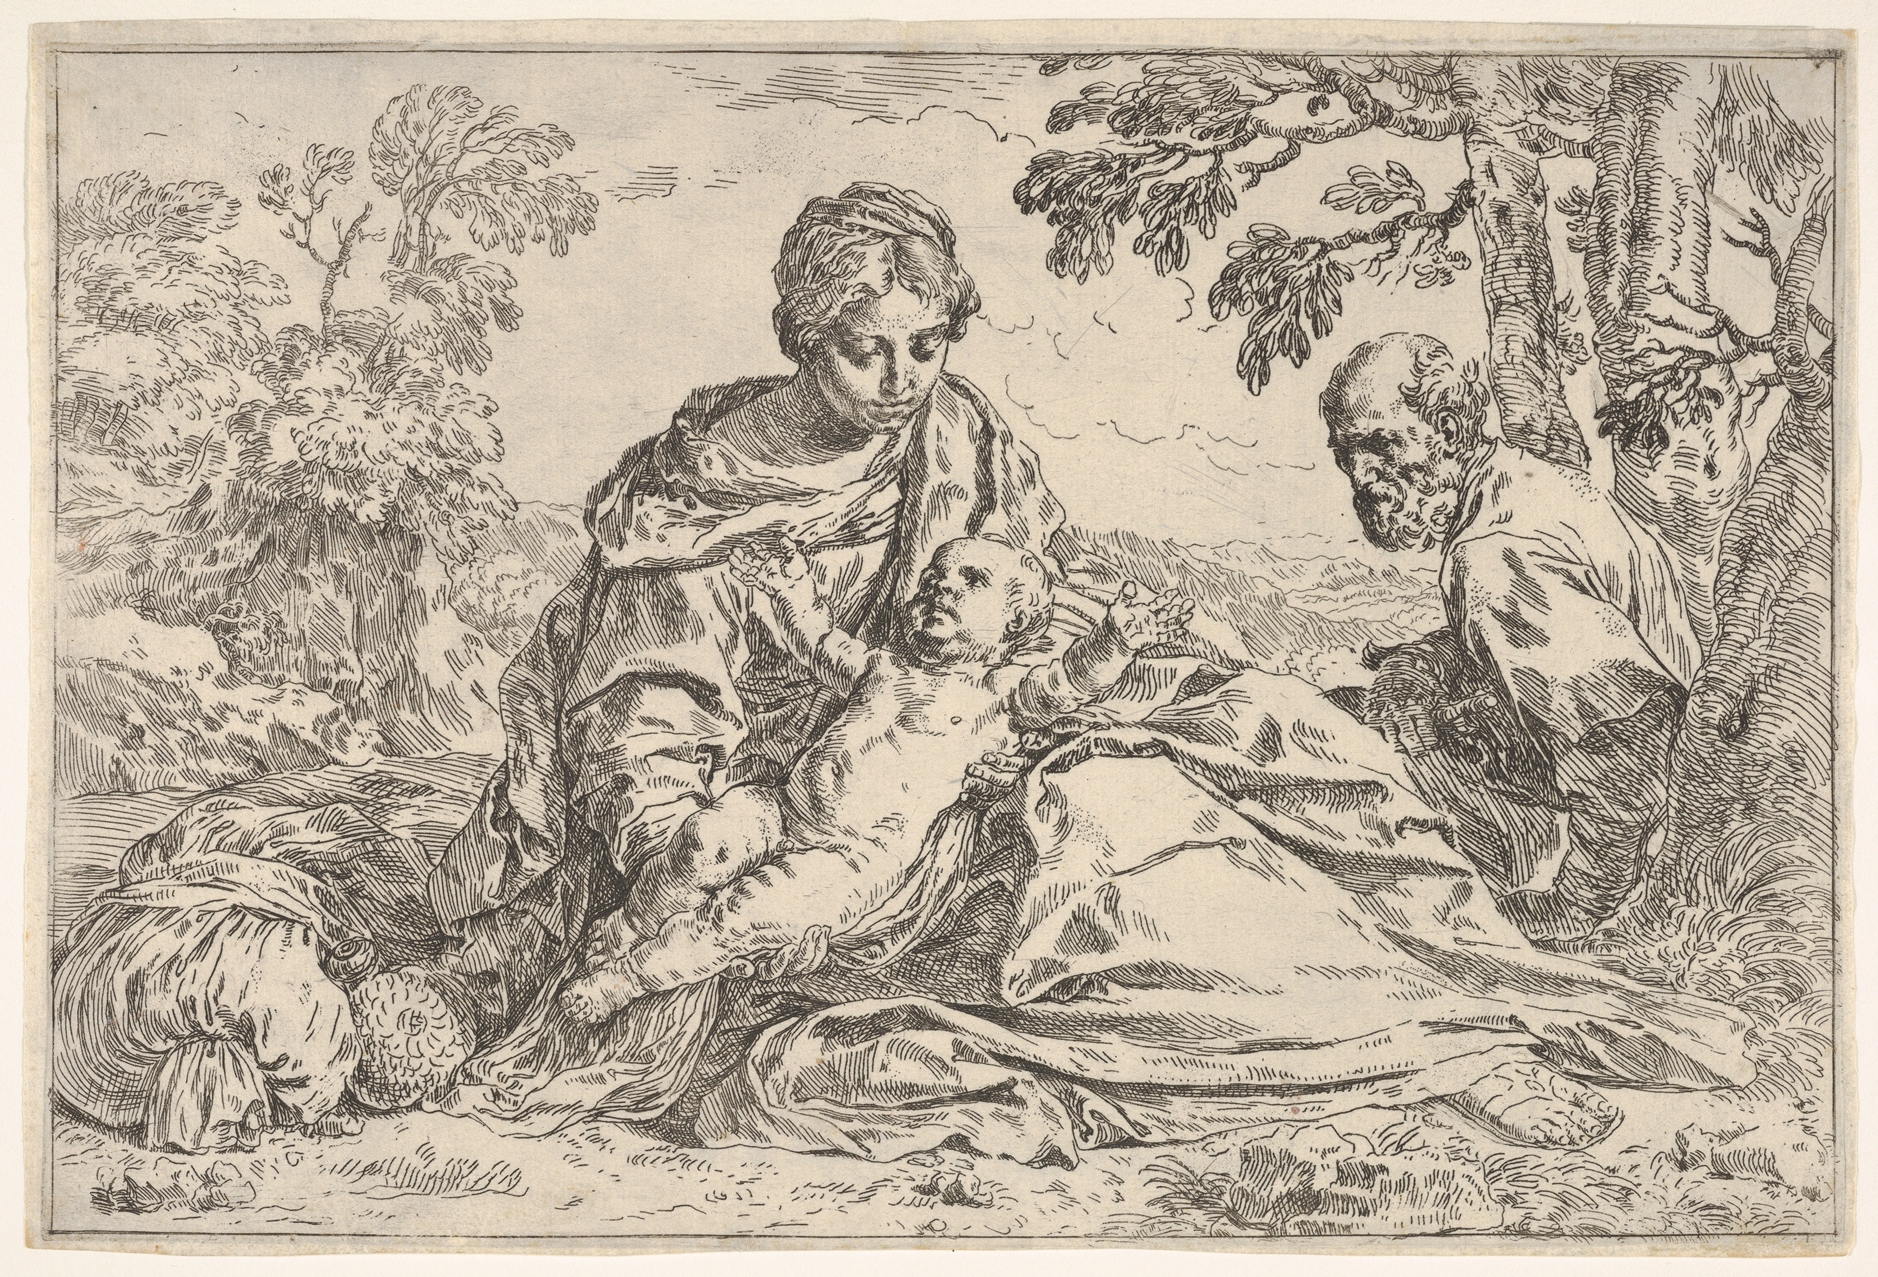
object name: print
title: Rest on the flight into Egypt, Mary holding the infant Christ with St. Joseph at right, copy after Cantarini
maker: simone cantarini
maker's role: artist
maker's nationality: italian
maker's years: 1612-1648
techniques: etching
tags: holy family